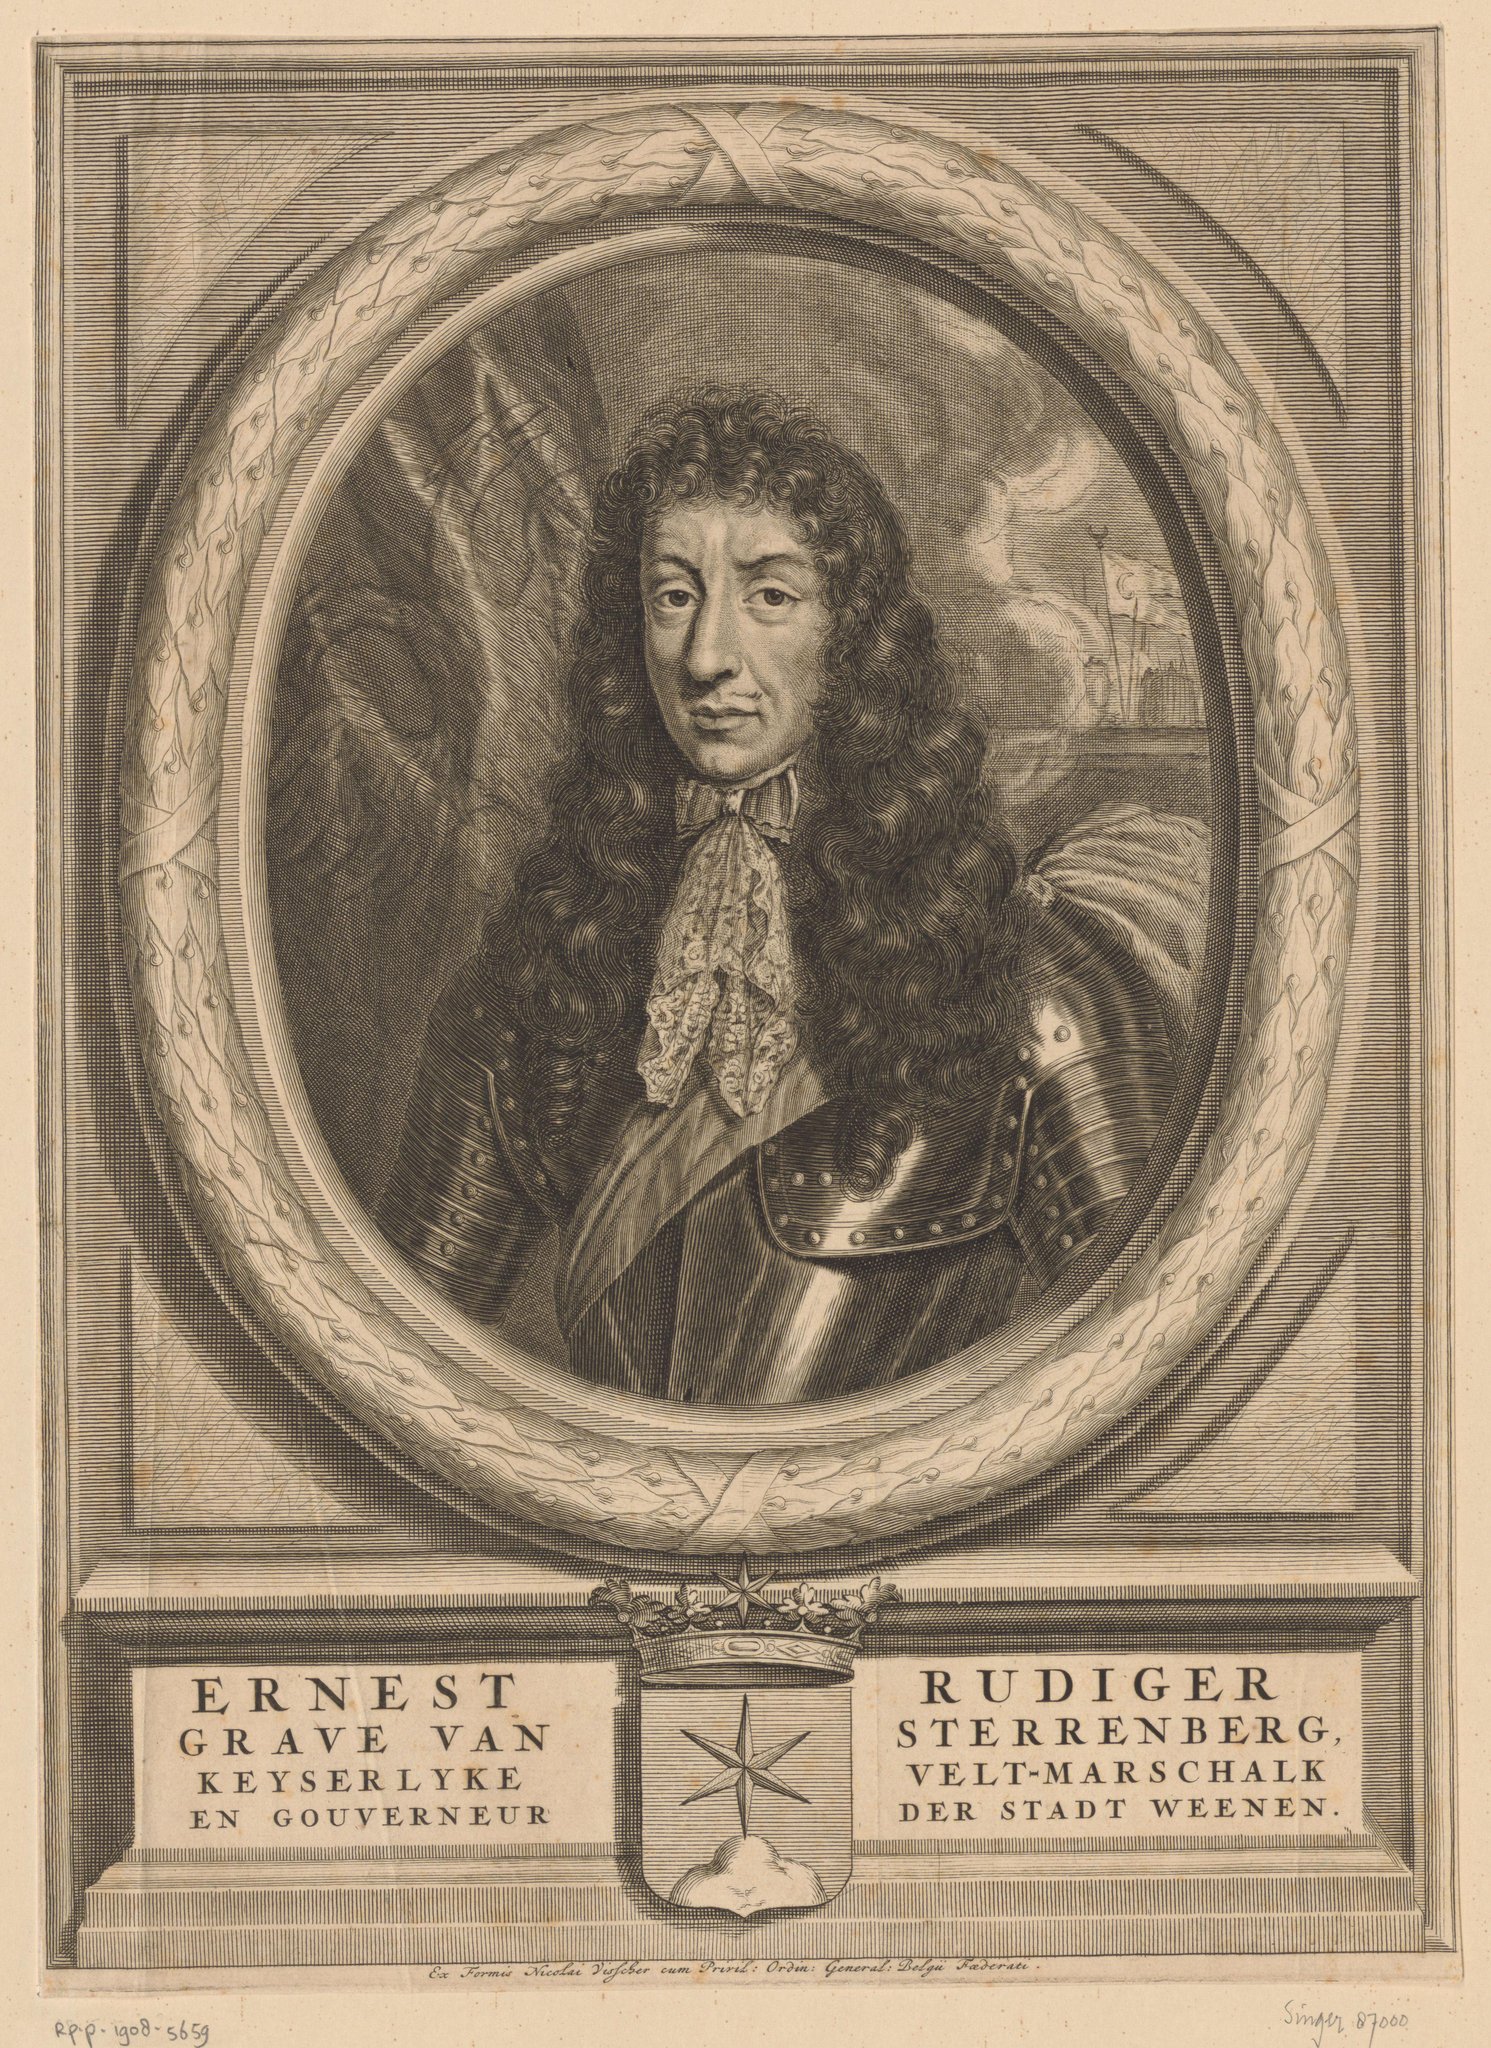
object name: print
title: Portret van Ernst Rüdiger van Starhemberg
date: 1659-1702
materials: paper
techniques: engraving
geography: amsterdam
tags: ernst rüdiger van starhemberg, adult man, historical persons, armorial bearing, heraldry, (military) flags and standards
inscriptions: collector's mark: Lugt 2161, collector's mark: Lugt 2228